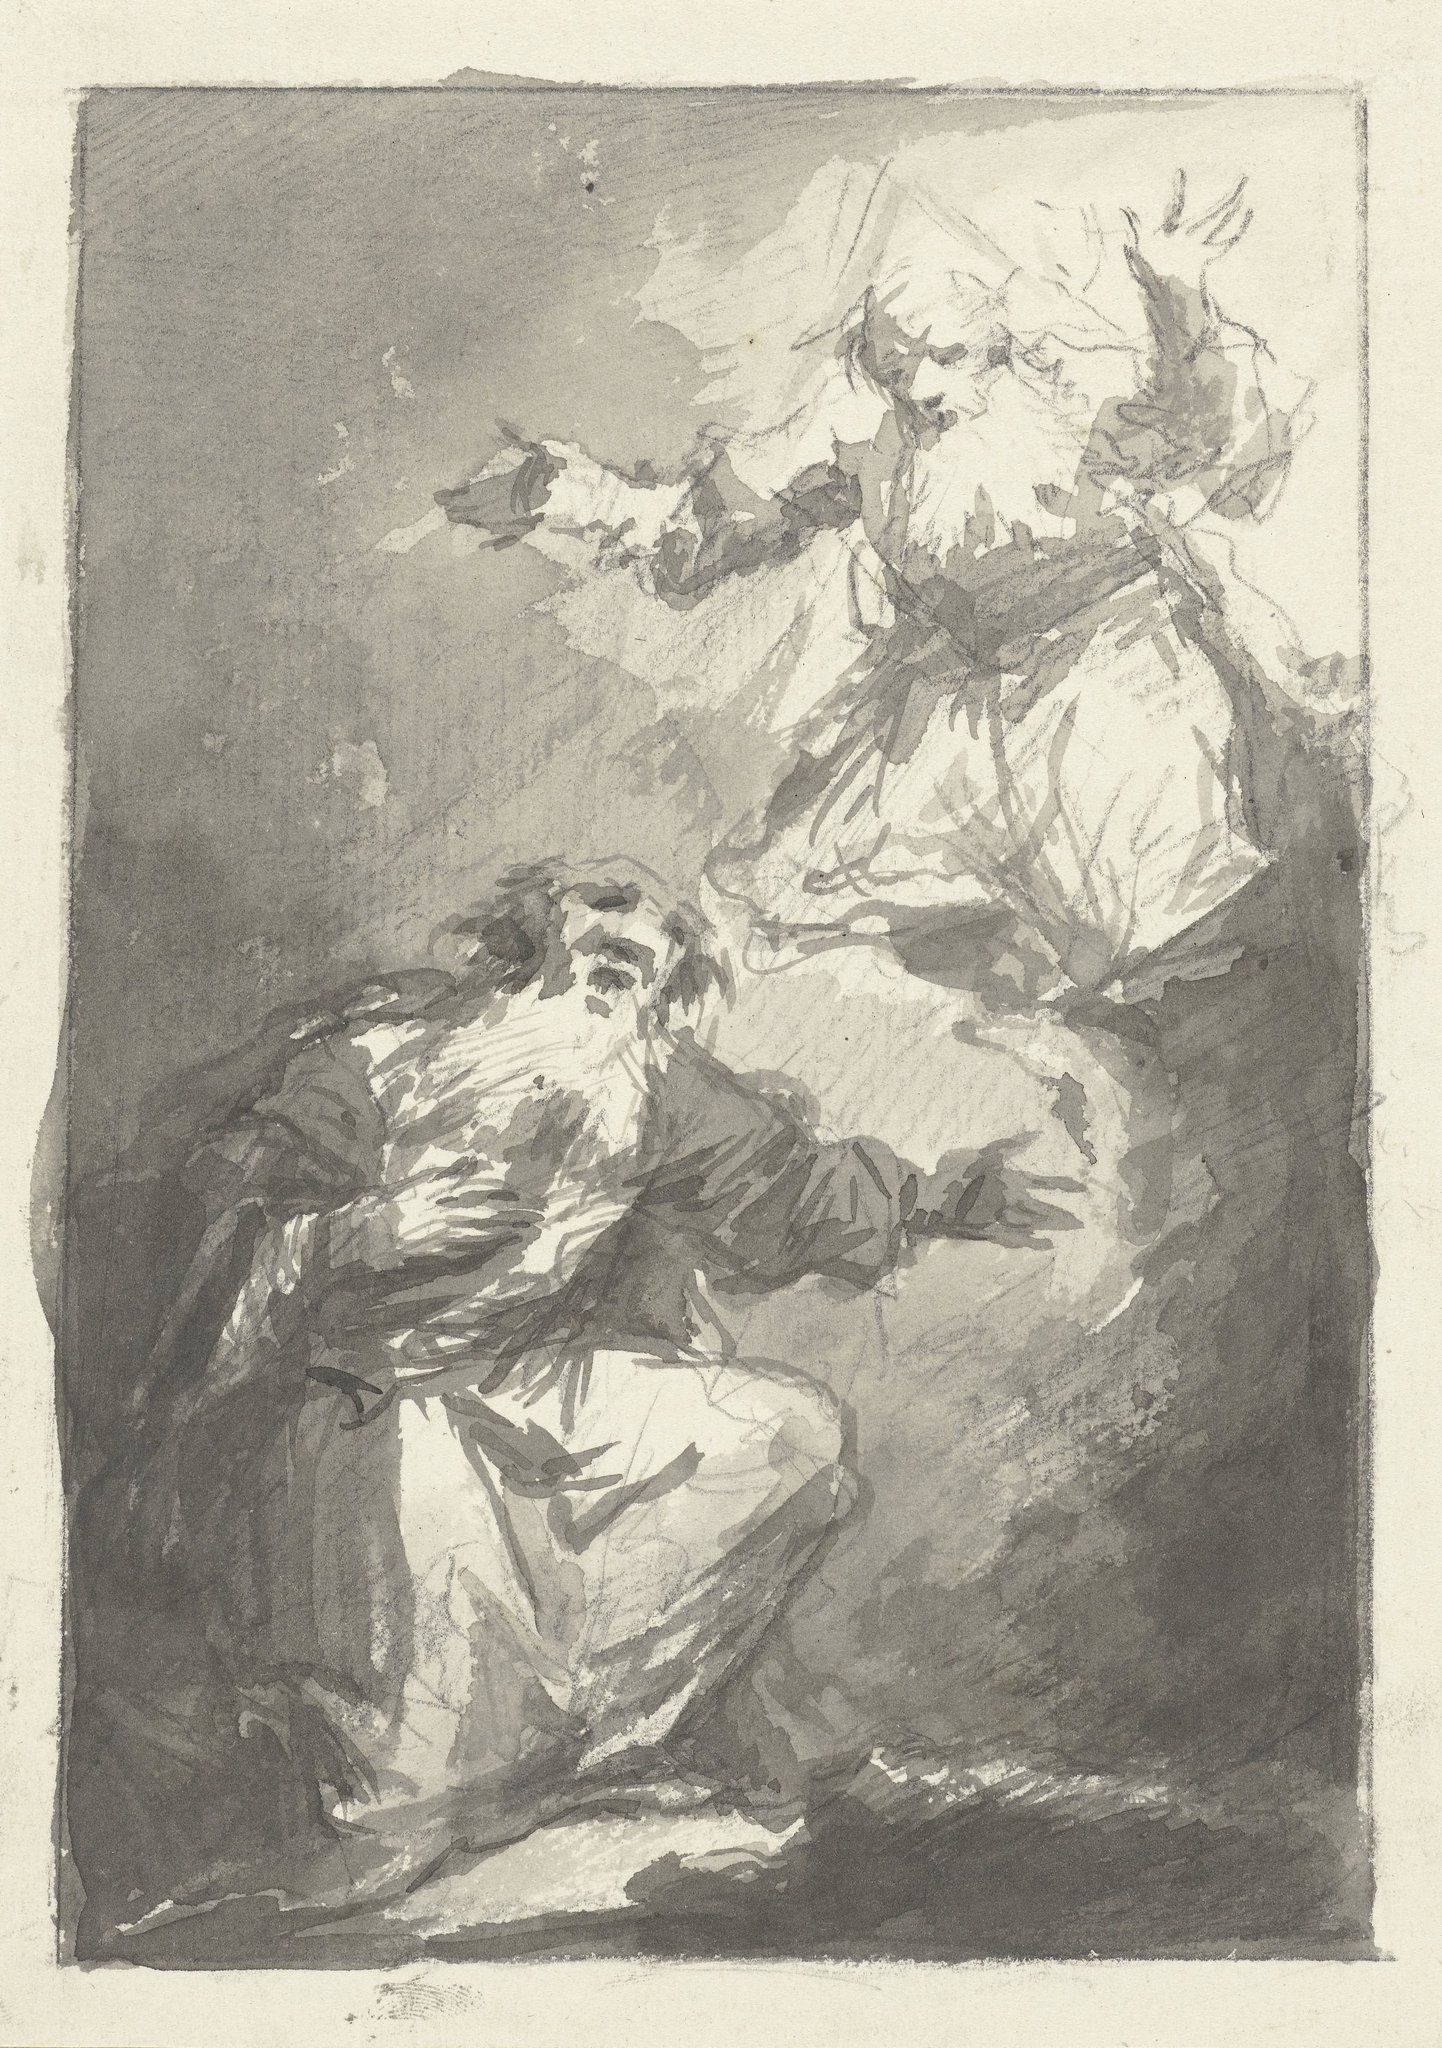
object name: drawing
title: God verschijnt aan Abraham of Mozes (?)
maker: johann georg trautmann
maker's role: draughtsman, painter, print maker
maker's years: 1713-1769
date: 1723-1769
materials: chalk, paper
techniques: brush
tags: genesis: the patriarchs, exodus, leviticus, numbers, deuteronomy, joshua: from the bondage of the israelites in egypt to their settlement in canaan